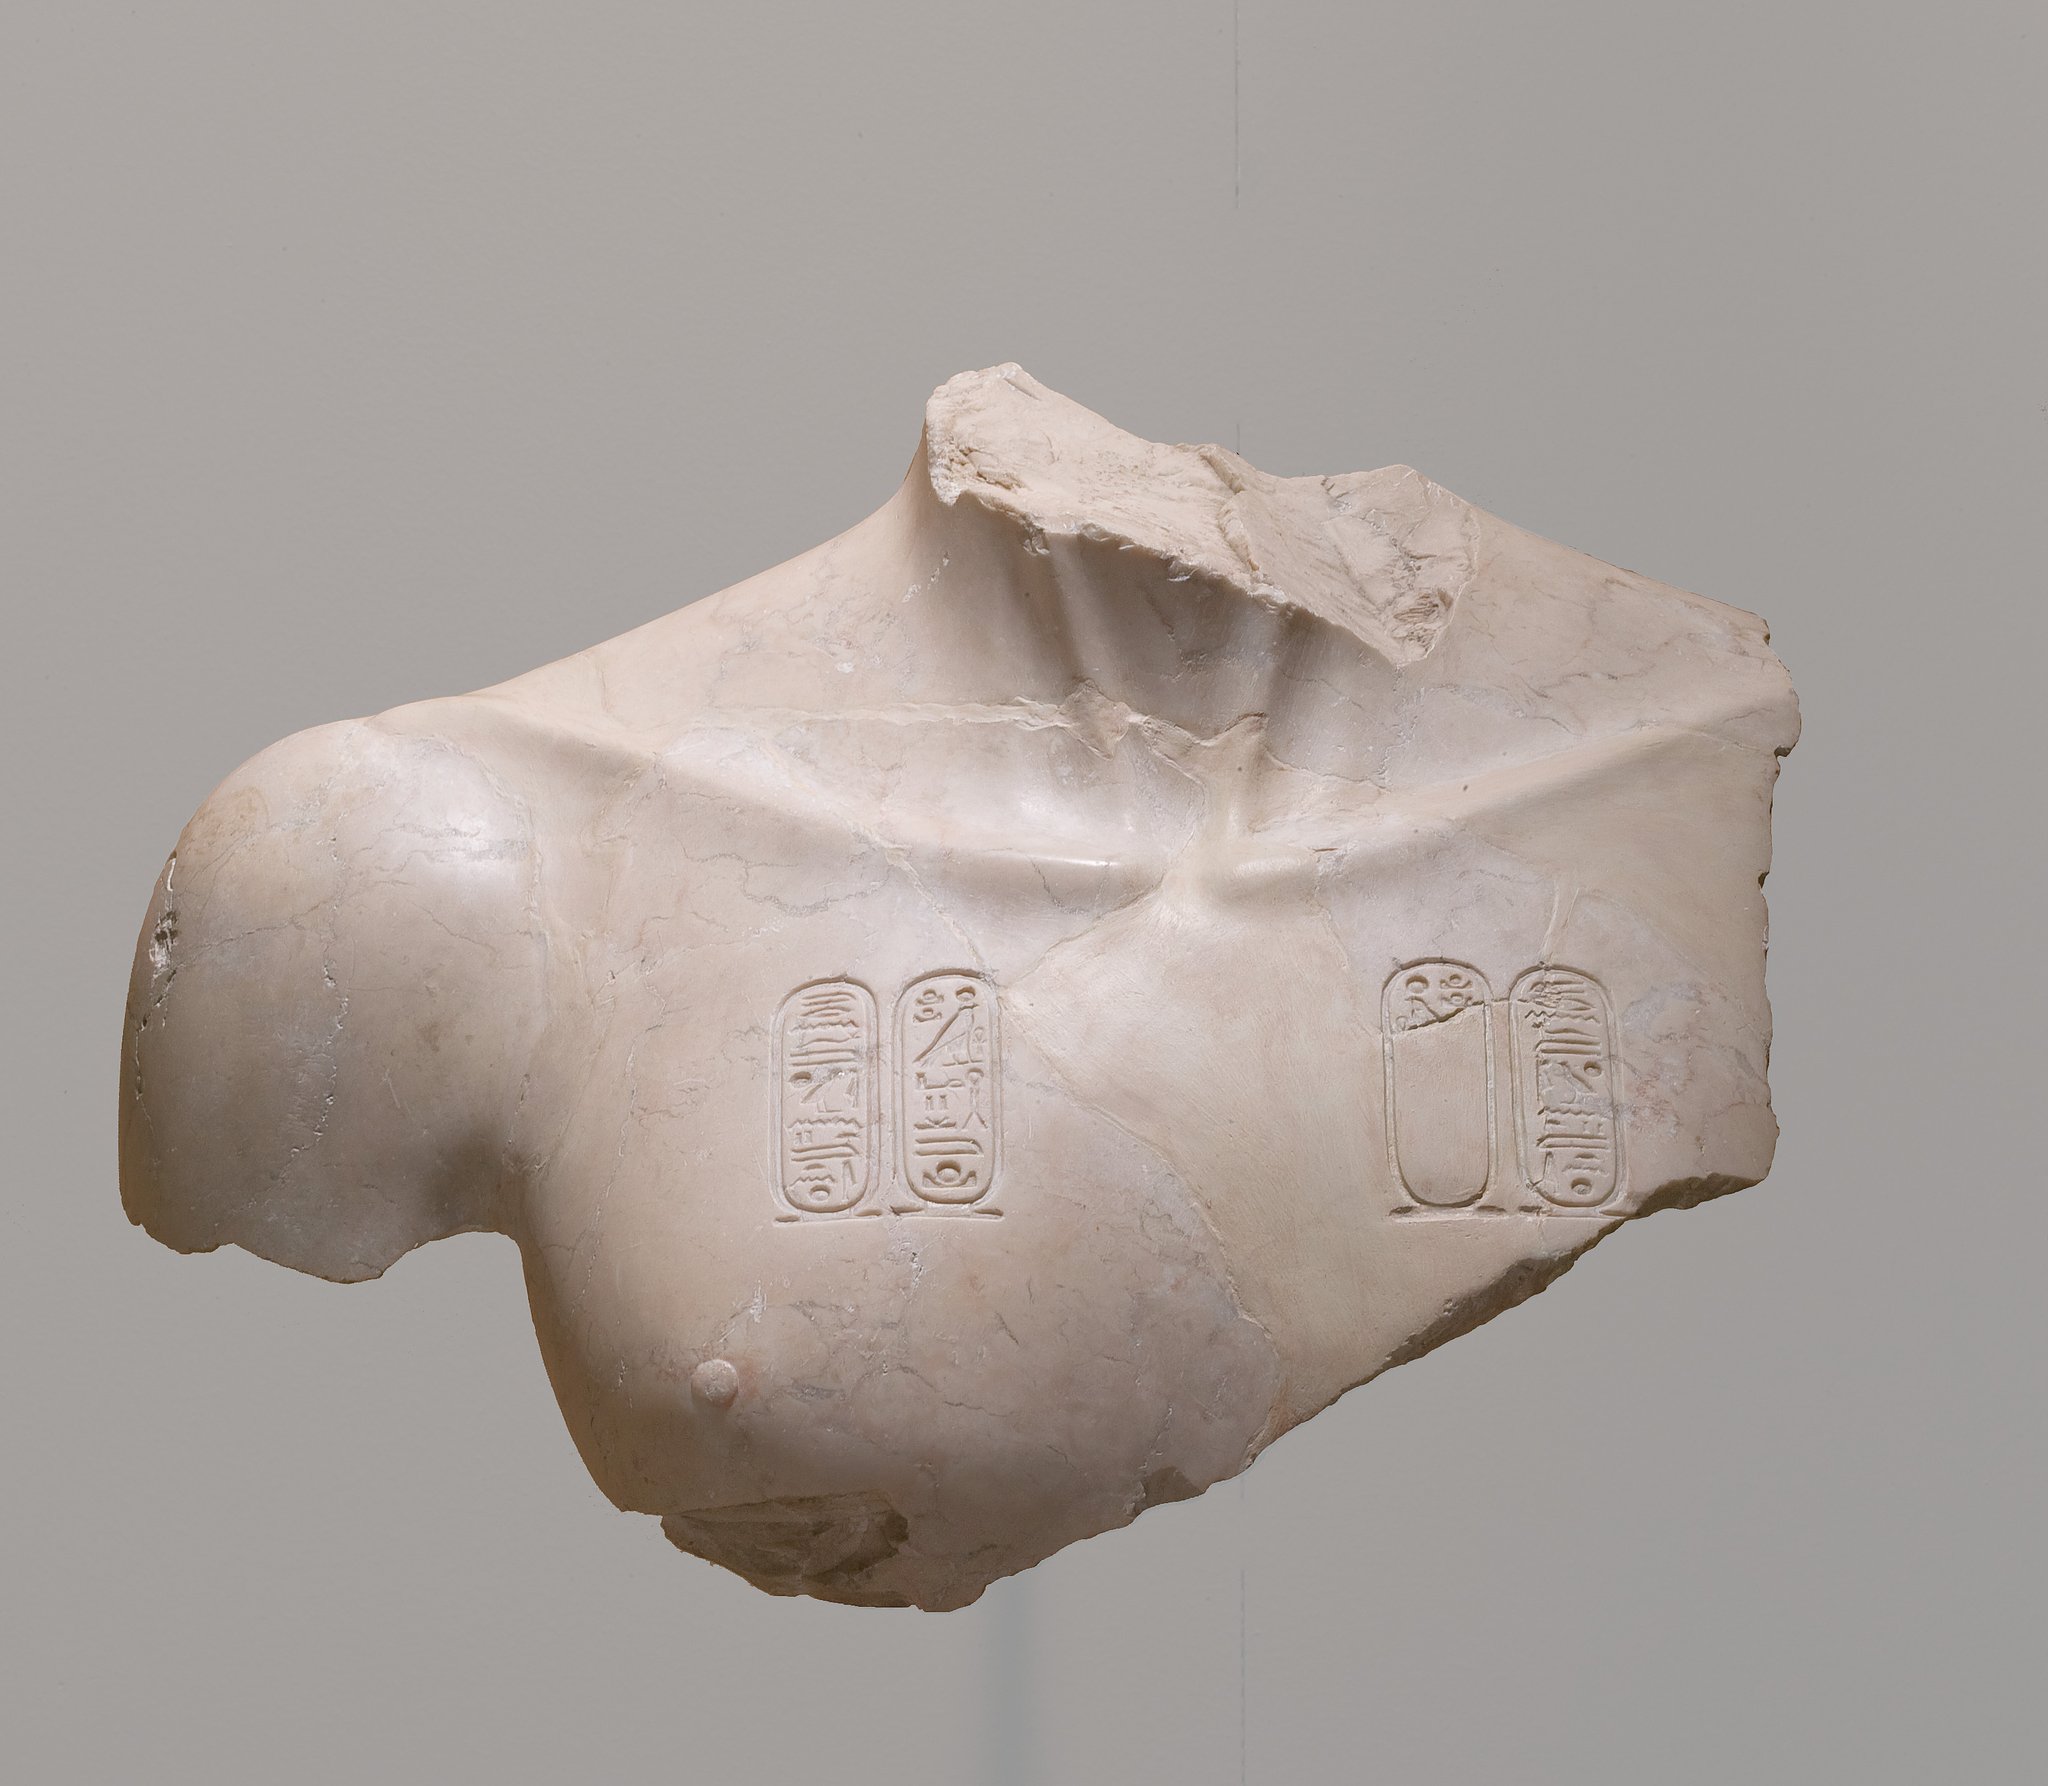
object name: chest, akhenaten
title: Chest of Akhenaten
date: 1352-1336 BCE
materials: limestone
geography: egypt